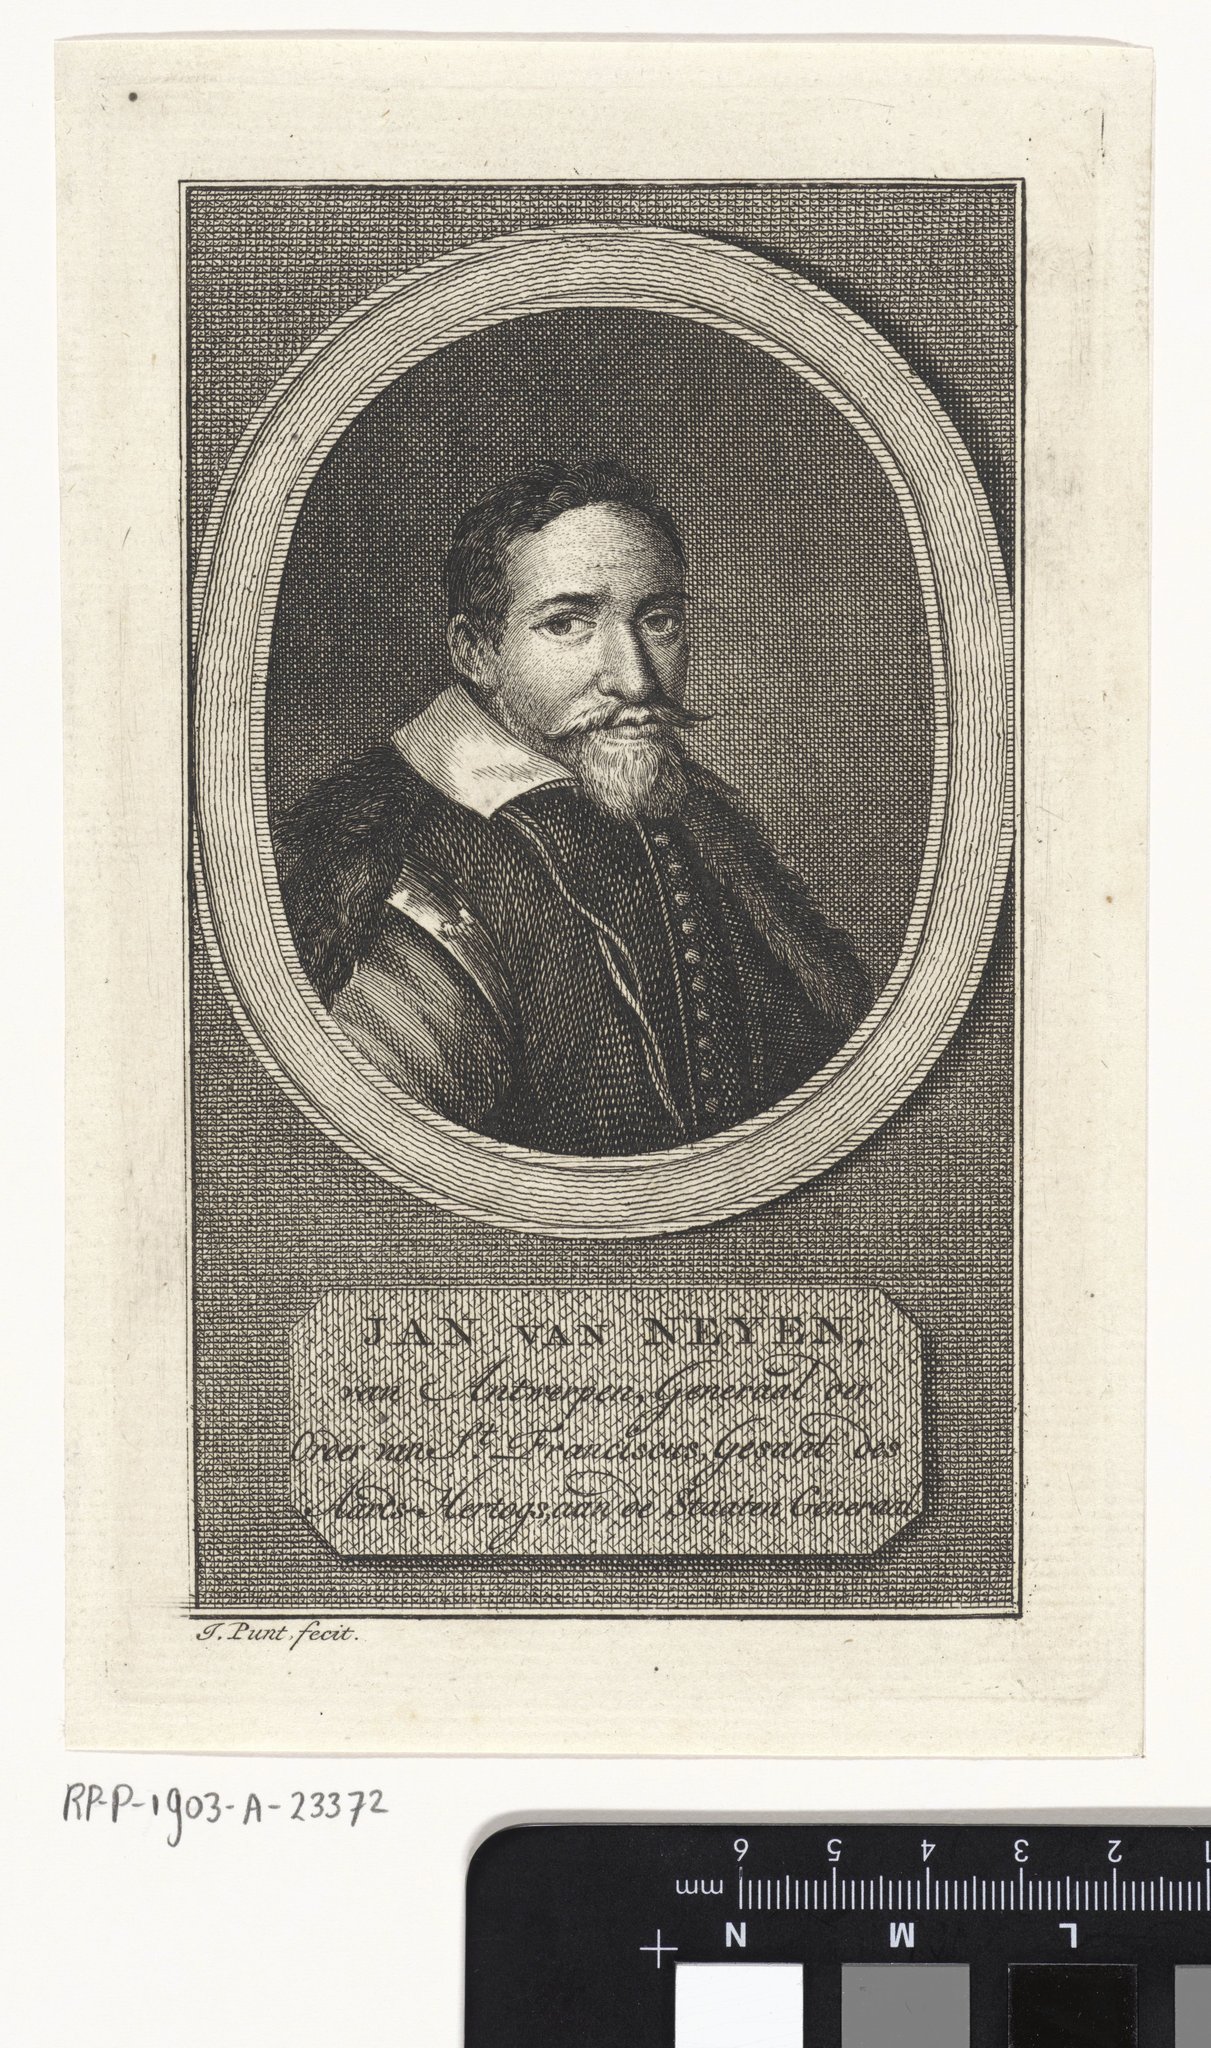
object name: book illustration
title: Portret van Jan Neyen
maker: jan punt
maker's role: draughtsman, print maker, publisher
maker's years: 1711-1779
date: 1786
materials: paper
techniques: engraving, etching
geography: northern netherlands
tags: antwerp, spain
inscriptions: collector's mark: Lugt 2228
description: Prent gebruikt als illustratie in: Meteren, Emanuel van. Oorlogen en geschiedenissen der Nederlanderen en derzelver nabuuren, deel IX, p. 226. Amsterdam: Steven Jacobus Baalde, 1786.